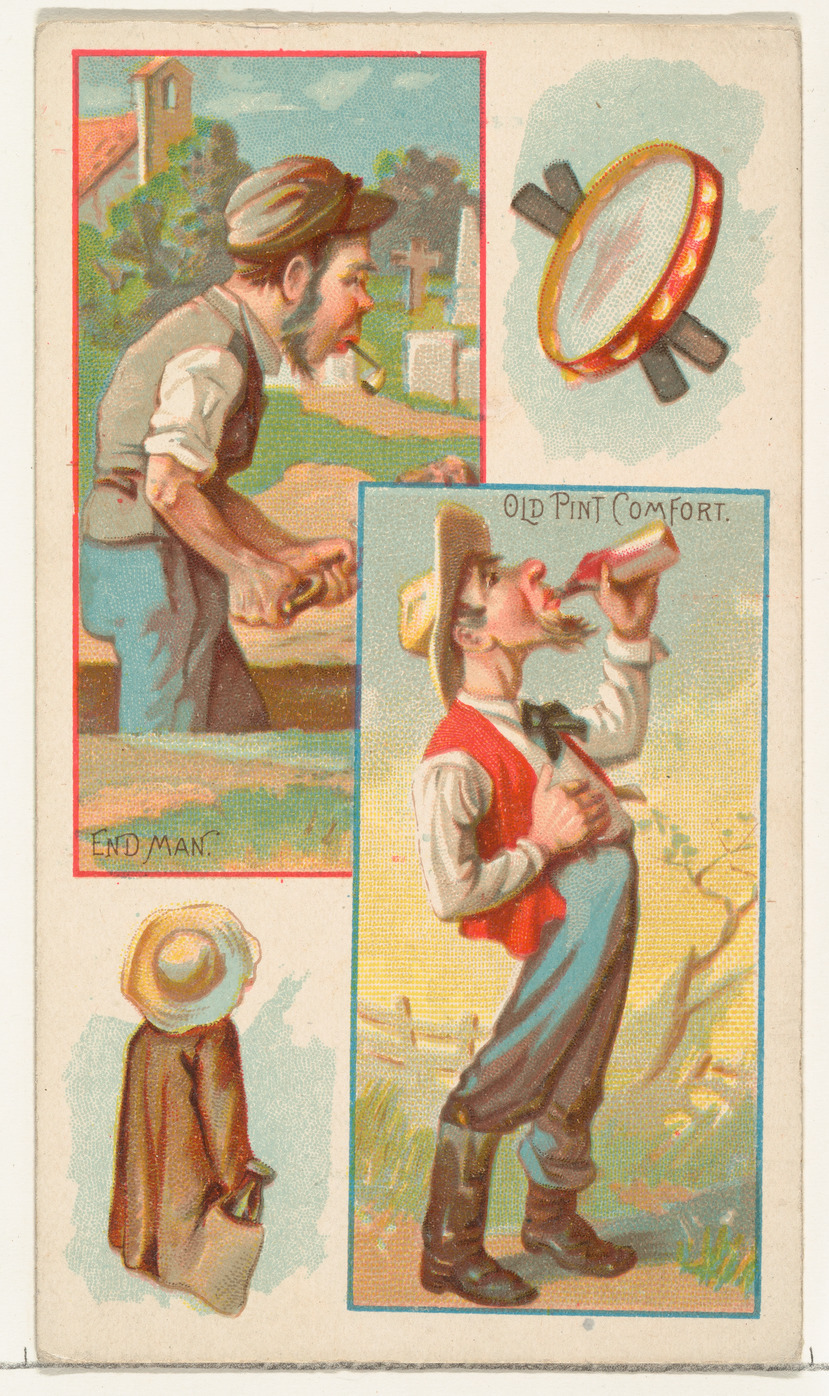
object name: print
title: End Man / Old Pint Comfort, from the Jokes series (N118) issued by Duke Sons & Co. to promote Honest Long Cut Tobacco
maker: w. duke, sons & co.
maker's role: publisher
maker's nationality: american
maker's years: 1870-1920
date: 1891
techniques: color lithograph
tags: men,smoking,drinking